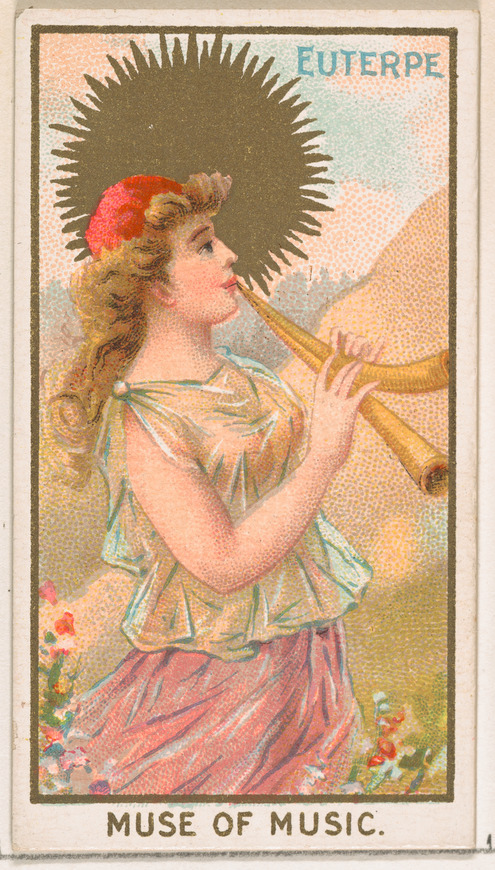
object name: print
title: Euterpe, Muse of Music, from the Goddesses of the Greeks and Romans series (N188) issued by Wm. S. Kimball & Co.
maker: william s. kimball & company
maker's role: publisher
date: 1889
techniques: color lithograph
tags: musical instruments,muses